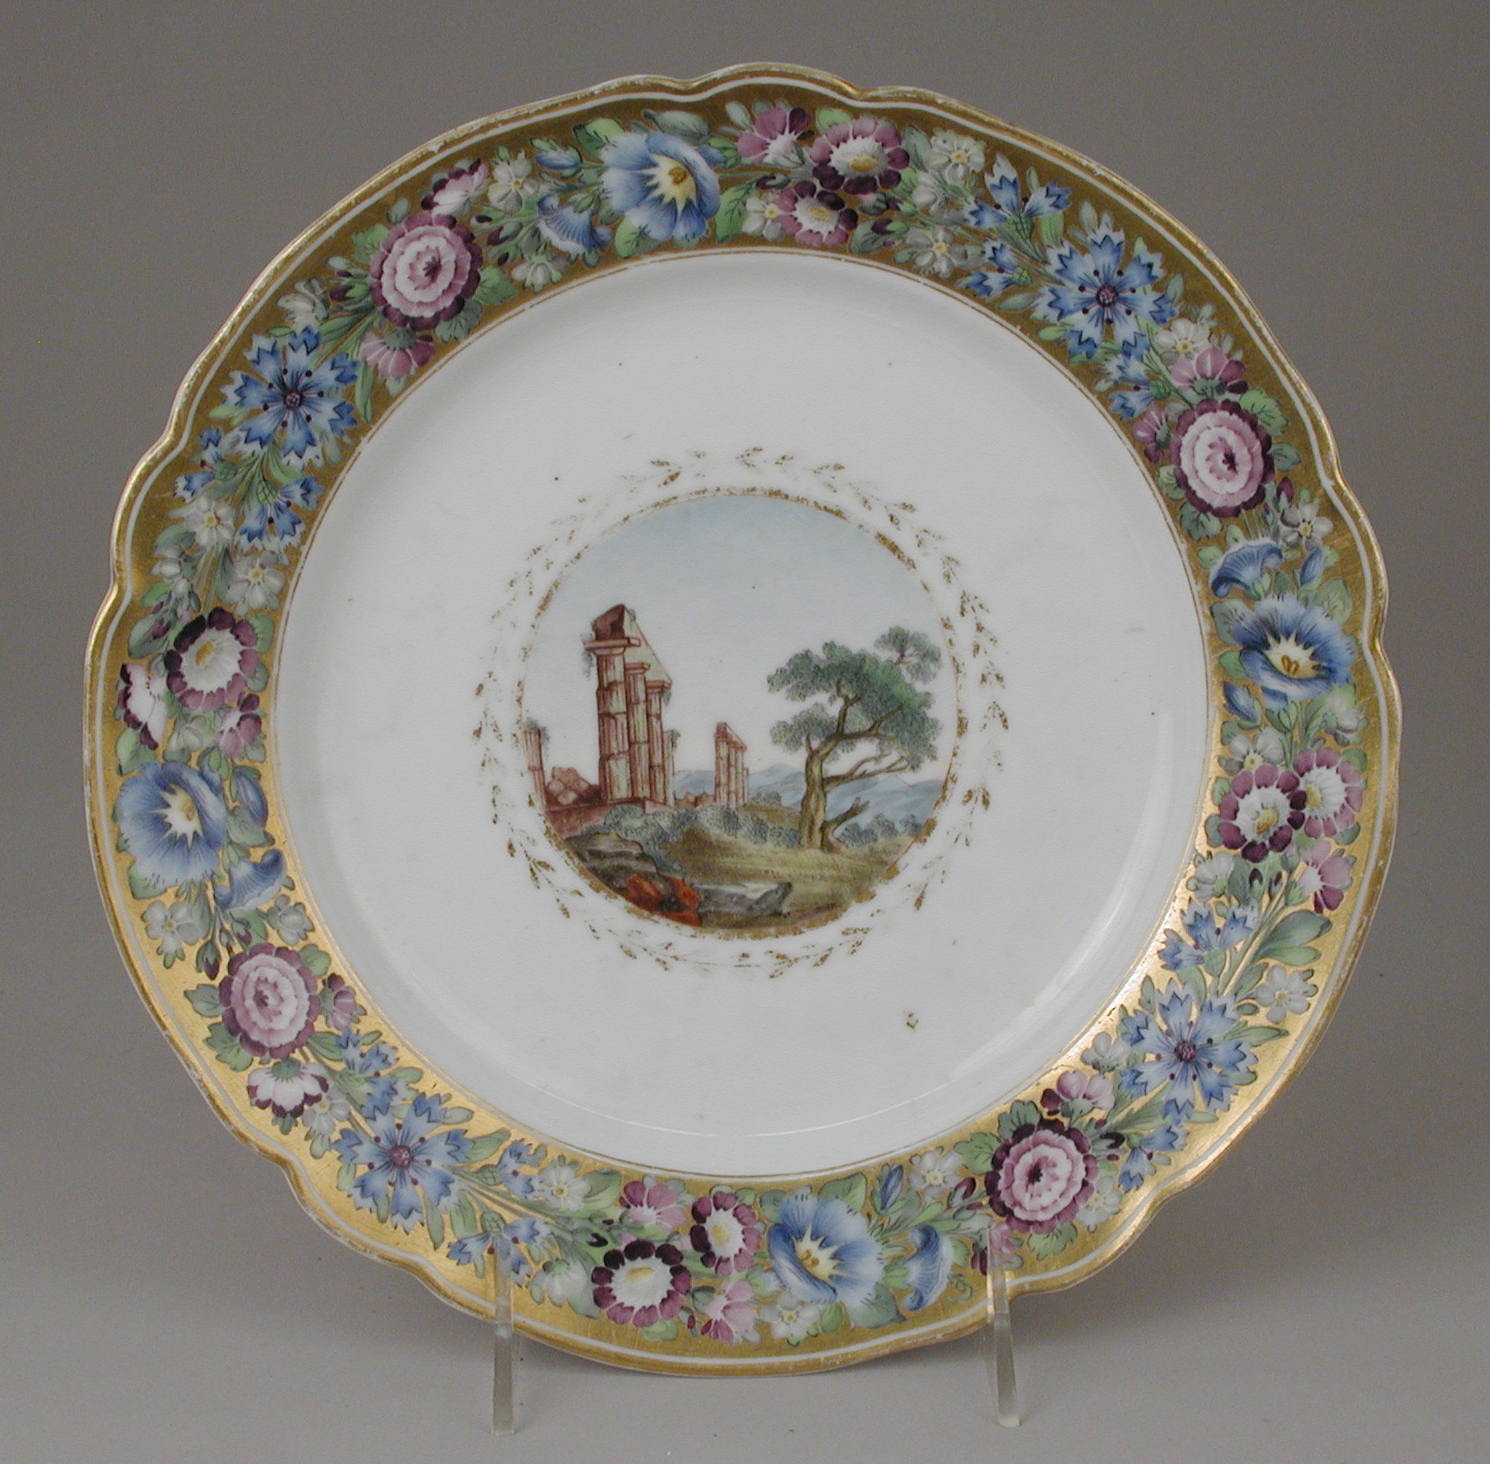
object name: plate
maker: imperial porcelain manufactory, st. petersburg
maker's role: manufactory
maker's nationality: russian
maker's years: 1744-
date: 1796-1801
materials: hard paste porcelain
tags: flowers,landscapes